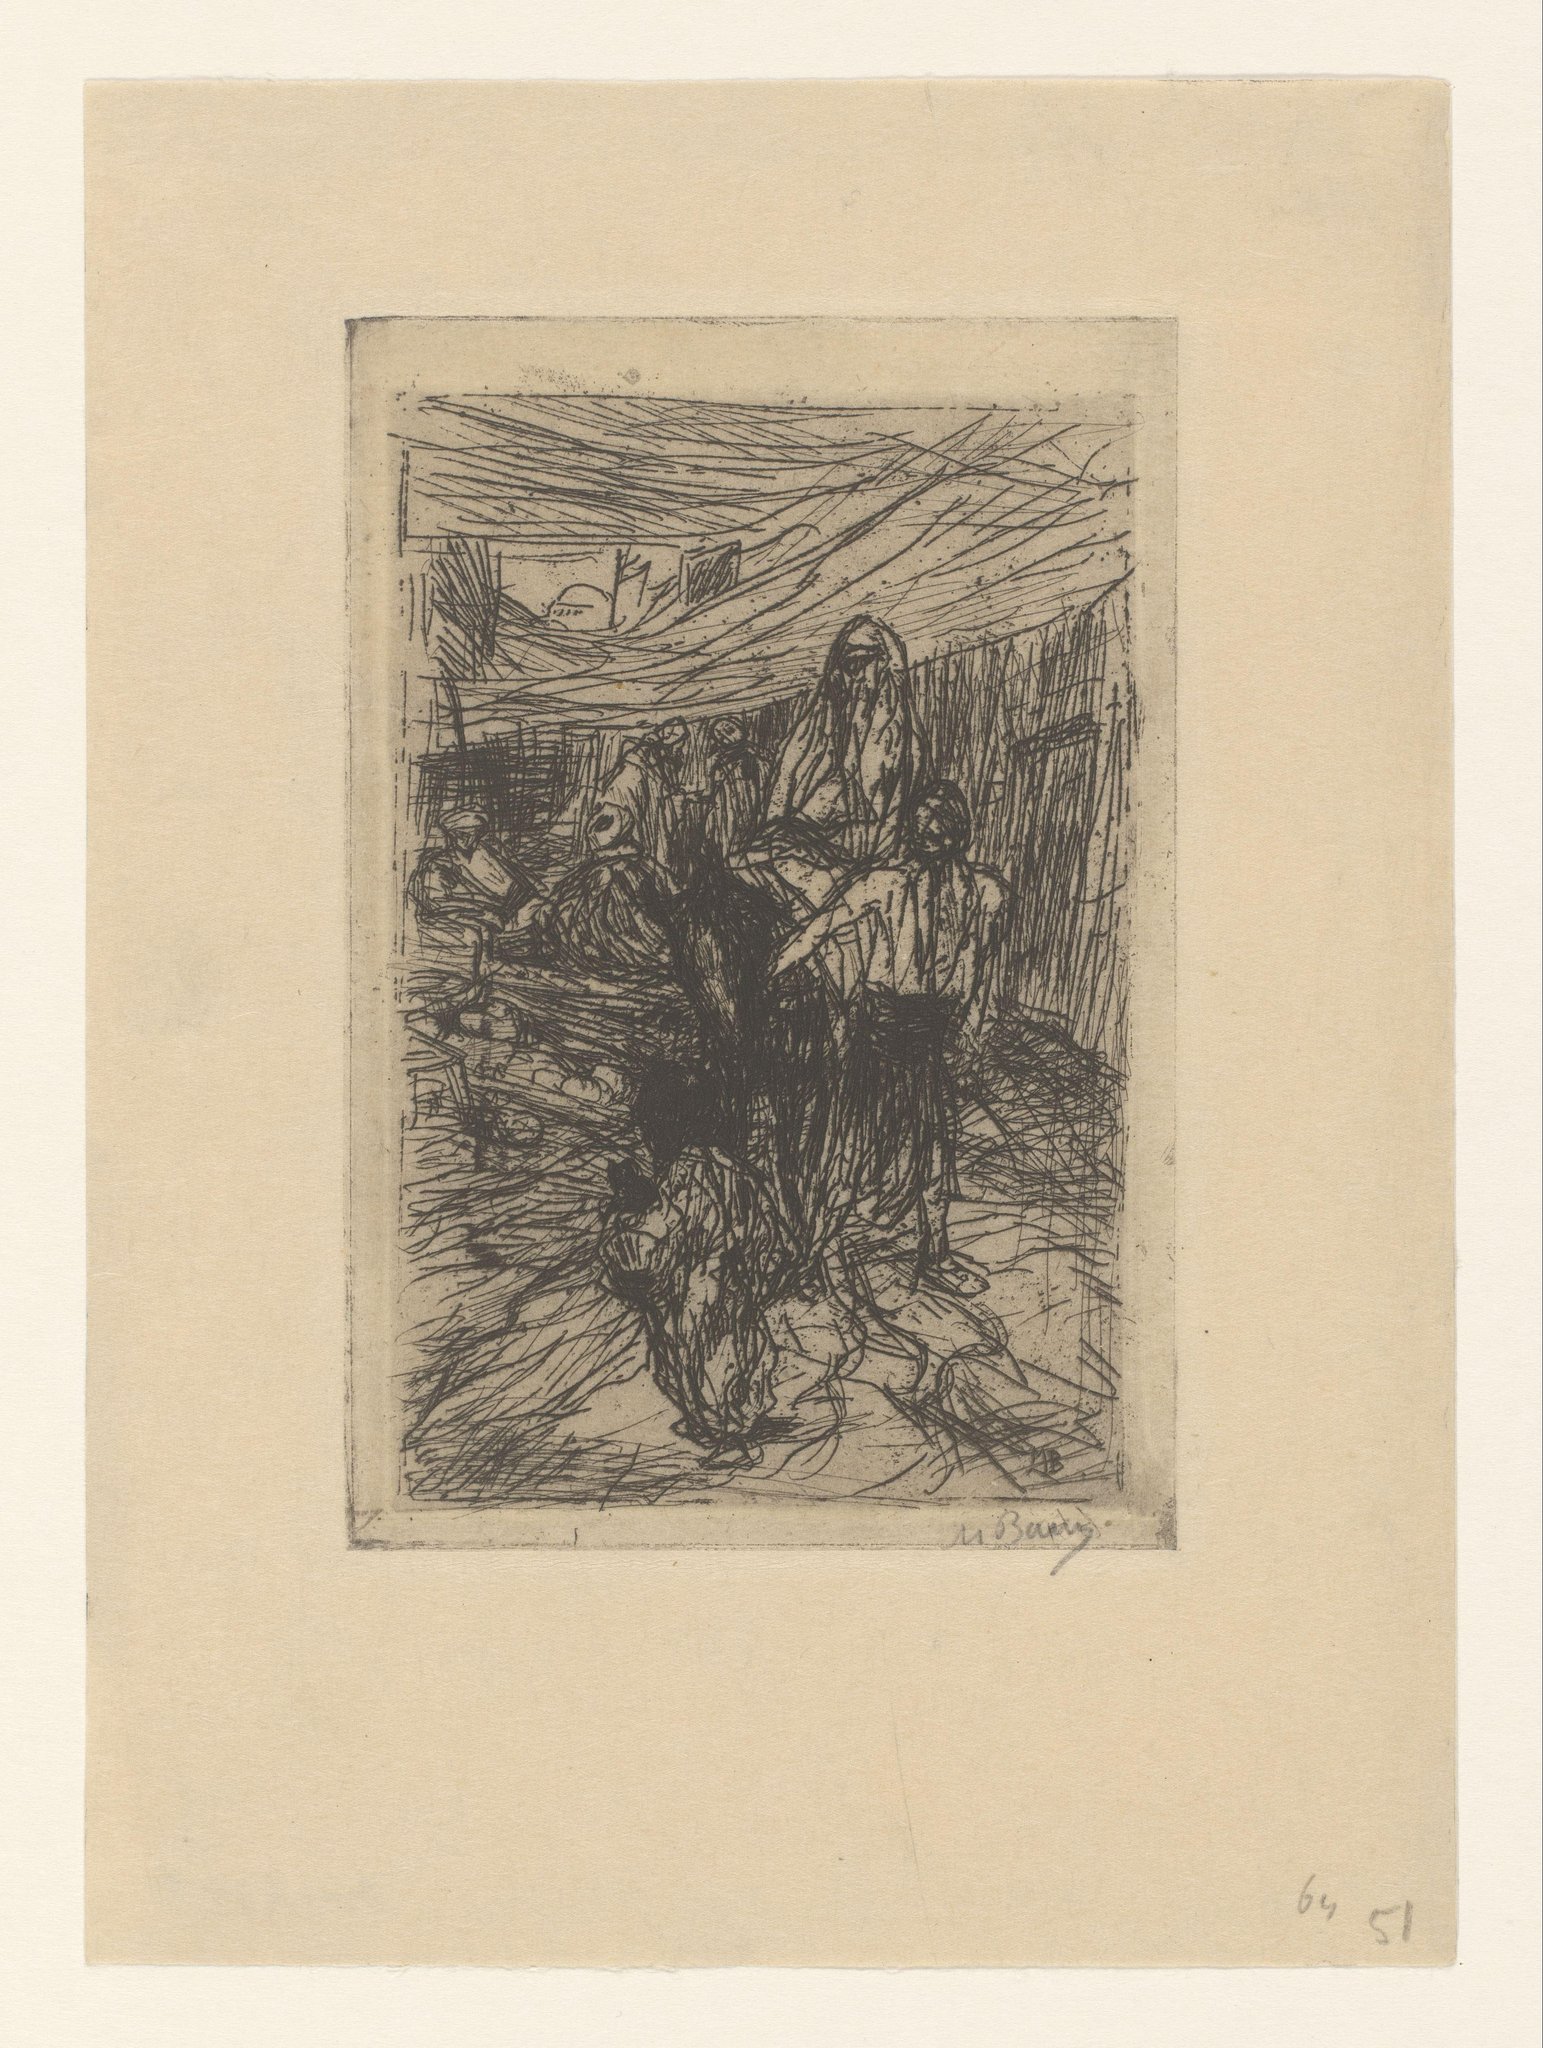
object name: print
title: Vrouw op een ezel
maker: marius bauer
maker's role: draughtsman, print maker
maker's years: 1867-1932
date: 1889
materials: paper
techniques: etching, intaglio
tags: riding a horse, ass, or mule; rider, horseman, ass, donkey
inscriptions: collector's mark: Lugt 2228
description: Een man leidt een ezel waar een gesluierde vrouw op zit door een straat.